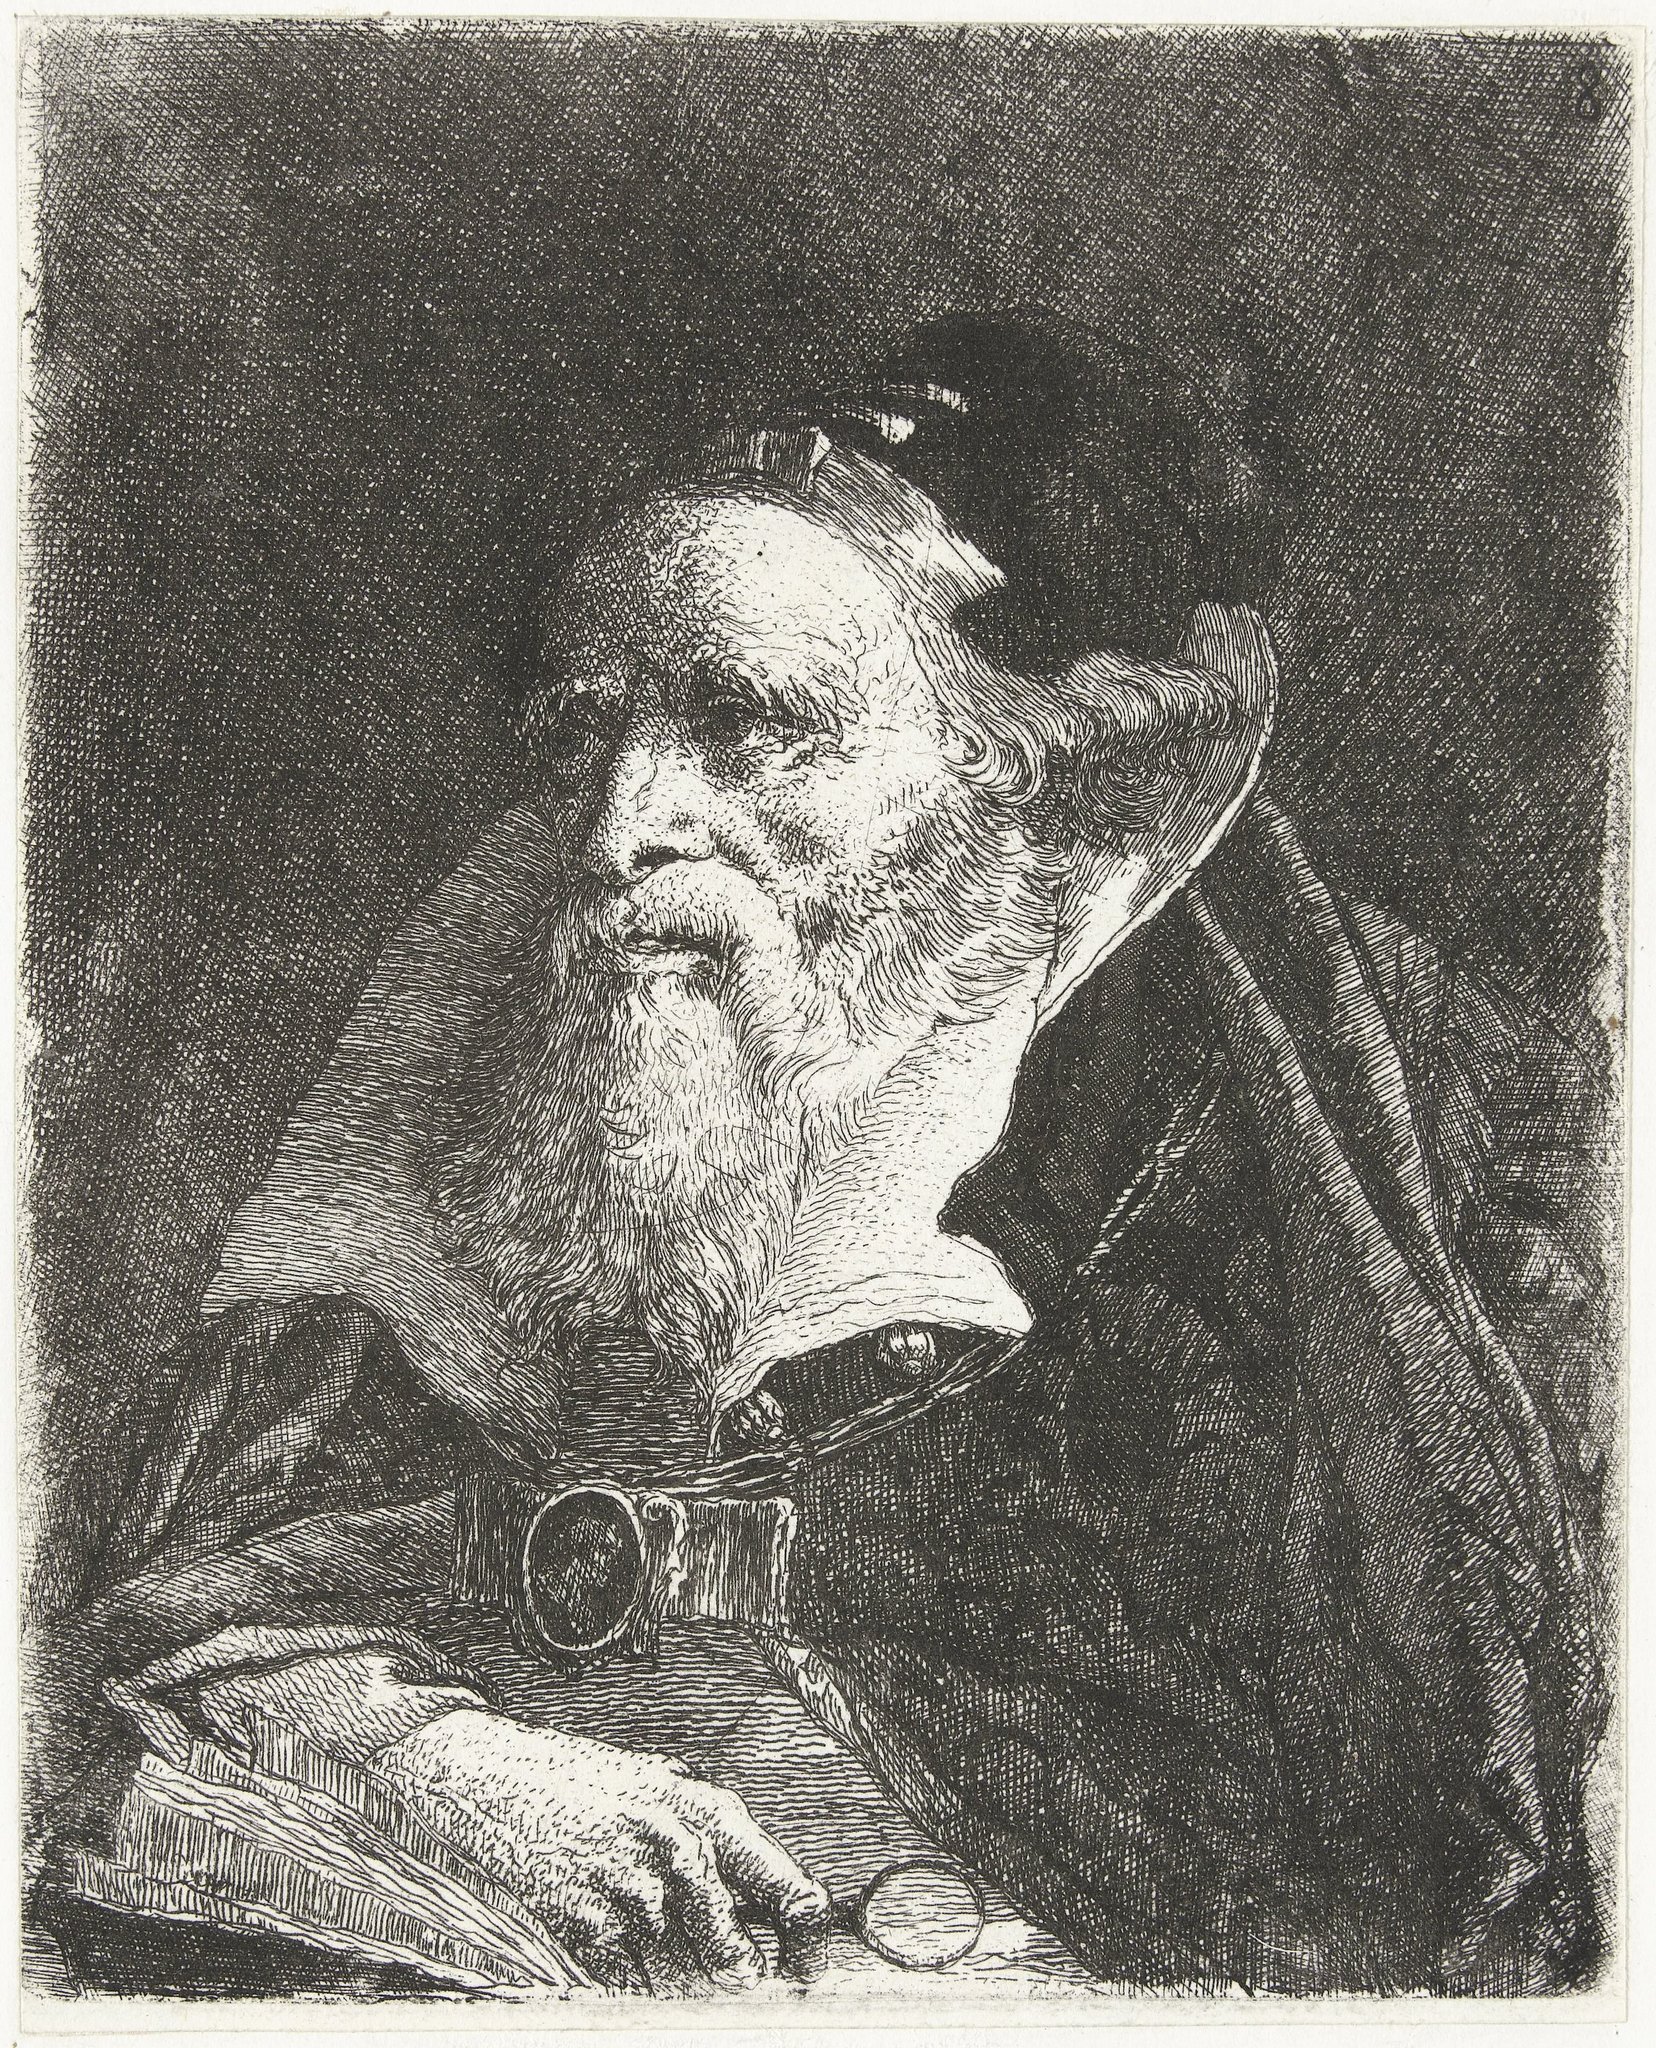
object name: print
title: Oude man met boek en vergrootglas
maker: giovanni domenico tiepolo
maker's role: draughtsman, print maker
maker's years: 1727-1804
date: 1757-1758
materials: paper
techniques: etching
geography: venice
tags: old man, magnifying glass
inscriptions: collector's mark: Lugt 2228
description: Prent uit serie Verzameling hoofden (Raccolta di teste). Giovanni Domenico Tiepolo vervaardigde in de winter van 1757-1758 en in de periode van 1771-1774 deze hoofden naar schilderijen en tekeningen van Giovanni Battista Tiepolo. De eerste uitgave verscheen in 1774 in twee delen met elk dertig prenten. Deze prent werd opgenomen in deel 1.